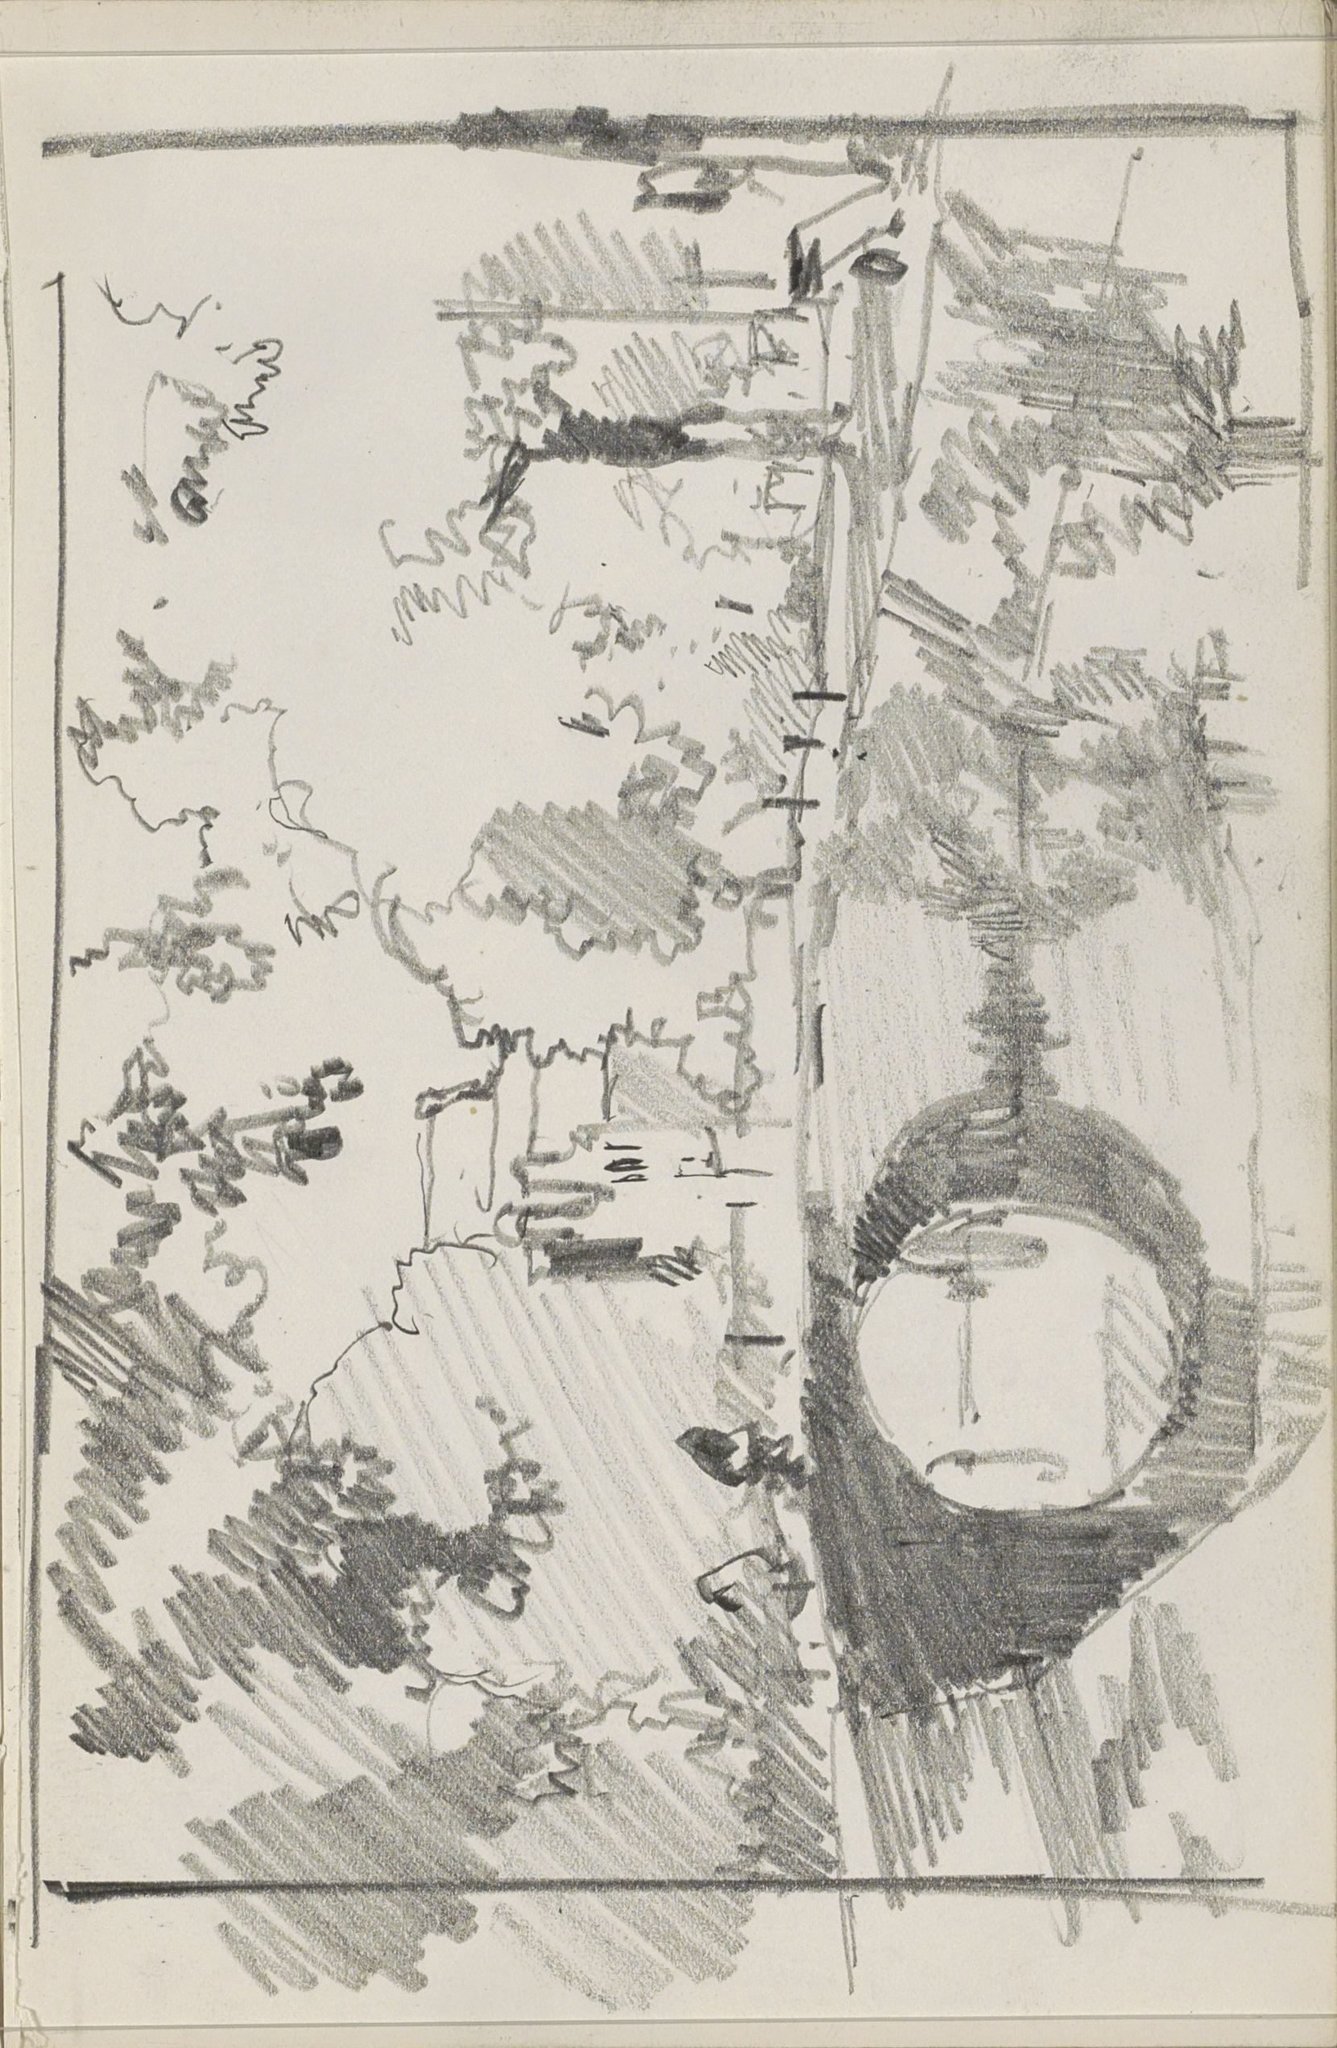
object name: sketchbook leaf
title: Brug over een gracht in een stad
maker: cornelis vreedenburgh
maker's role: draughtsman, print maker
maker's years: 1880-1946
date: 1890-1946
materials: paper, pencil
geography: amsterdam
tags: bridge in city across river, canal, etc.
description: Op de brug lopen figuren. Blad 15 recto uit een schetsboek met 41 bladen.